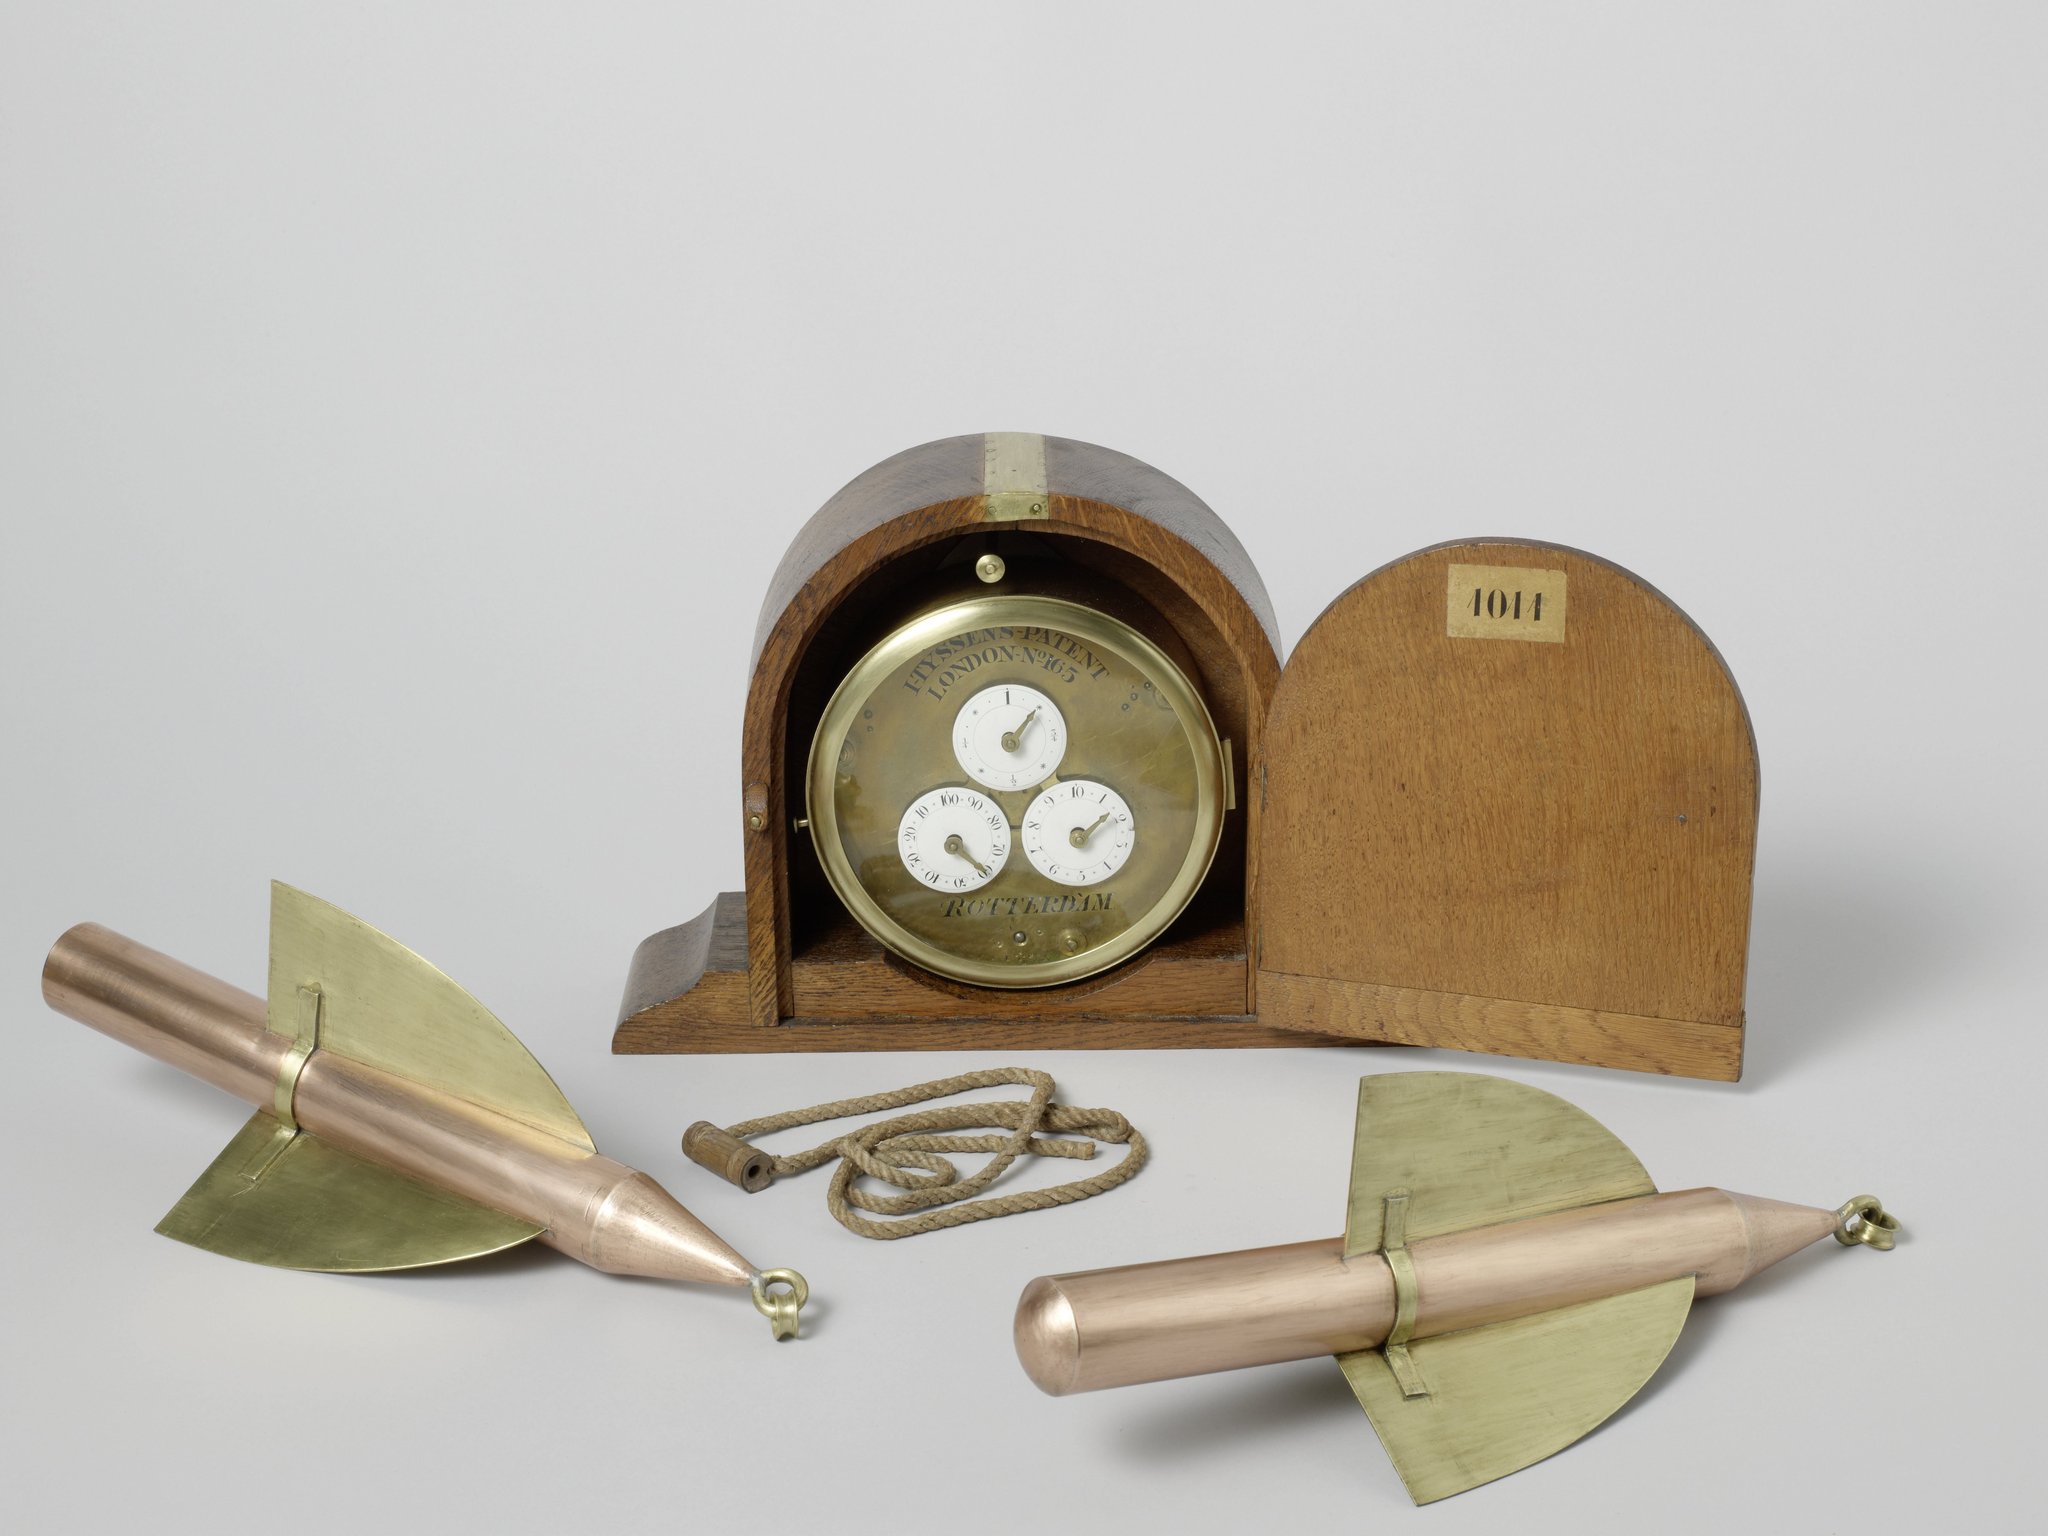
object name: rotating vane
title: Log with Two Rotating Vanes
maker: i. thyssen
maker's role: instrument maker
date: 1860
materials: brass, copper, iron, wood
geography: rotterdam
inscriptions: label, on the door: ‘1011’ former inventory label, inscription, on the dial: ‘I-THYSSEN’s-PATENT / LONDON-Nº 165 / ROTTERDAM’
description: Mechanisch log bestaande uit een heklog in een kastje en twee logvinnen, waarvan er een met een loglijn aan de keerzijde het heklog bevestigd moet worden; de tweede logvin dient als reserve. De logvinnen zijn cylindrische drijvers met drie schroefvormige vleugels, die het heklog in de richting van de klok aandrijven. Het ronde heklog heeft drie emaille wijzerplaten, voor 1 mijl (onderverdeeld in zestienden), 10 mijl en 100 mijl.